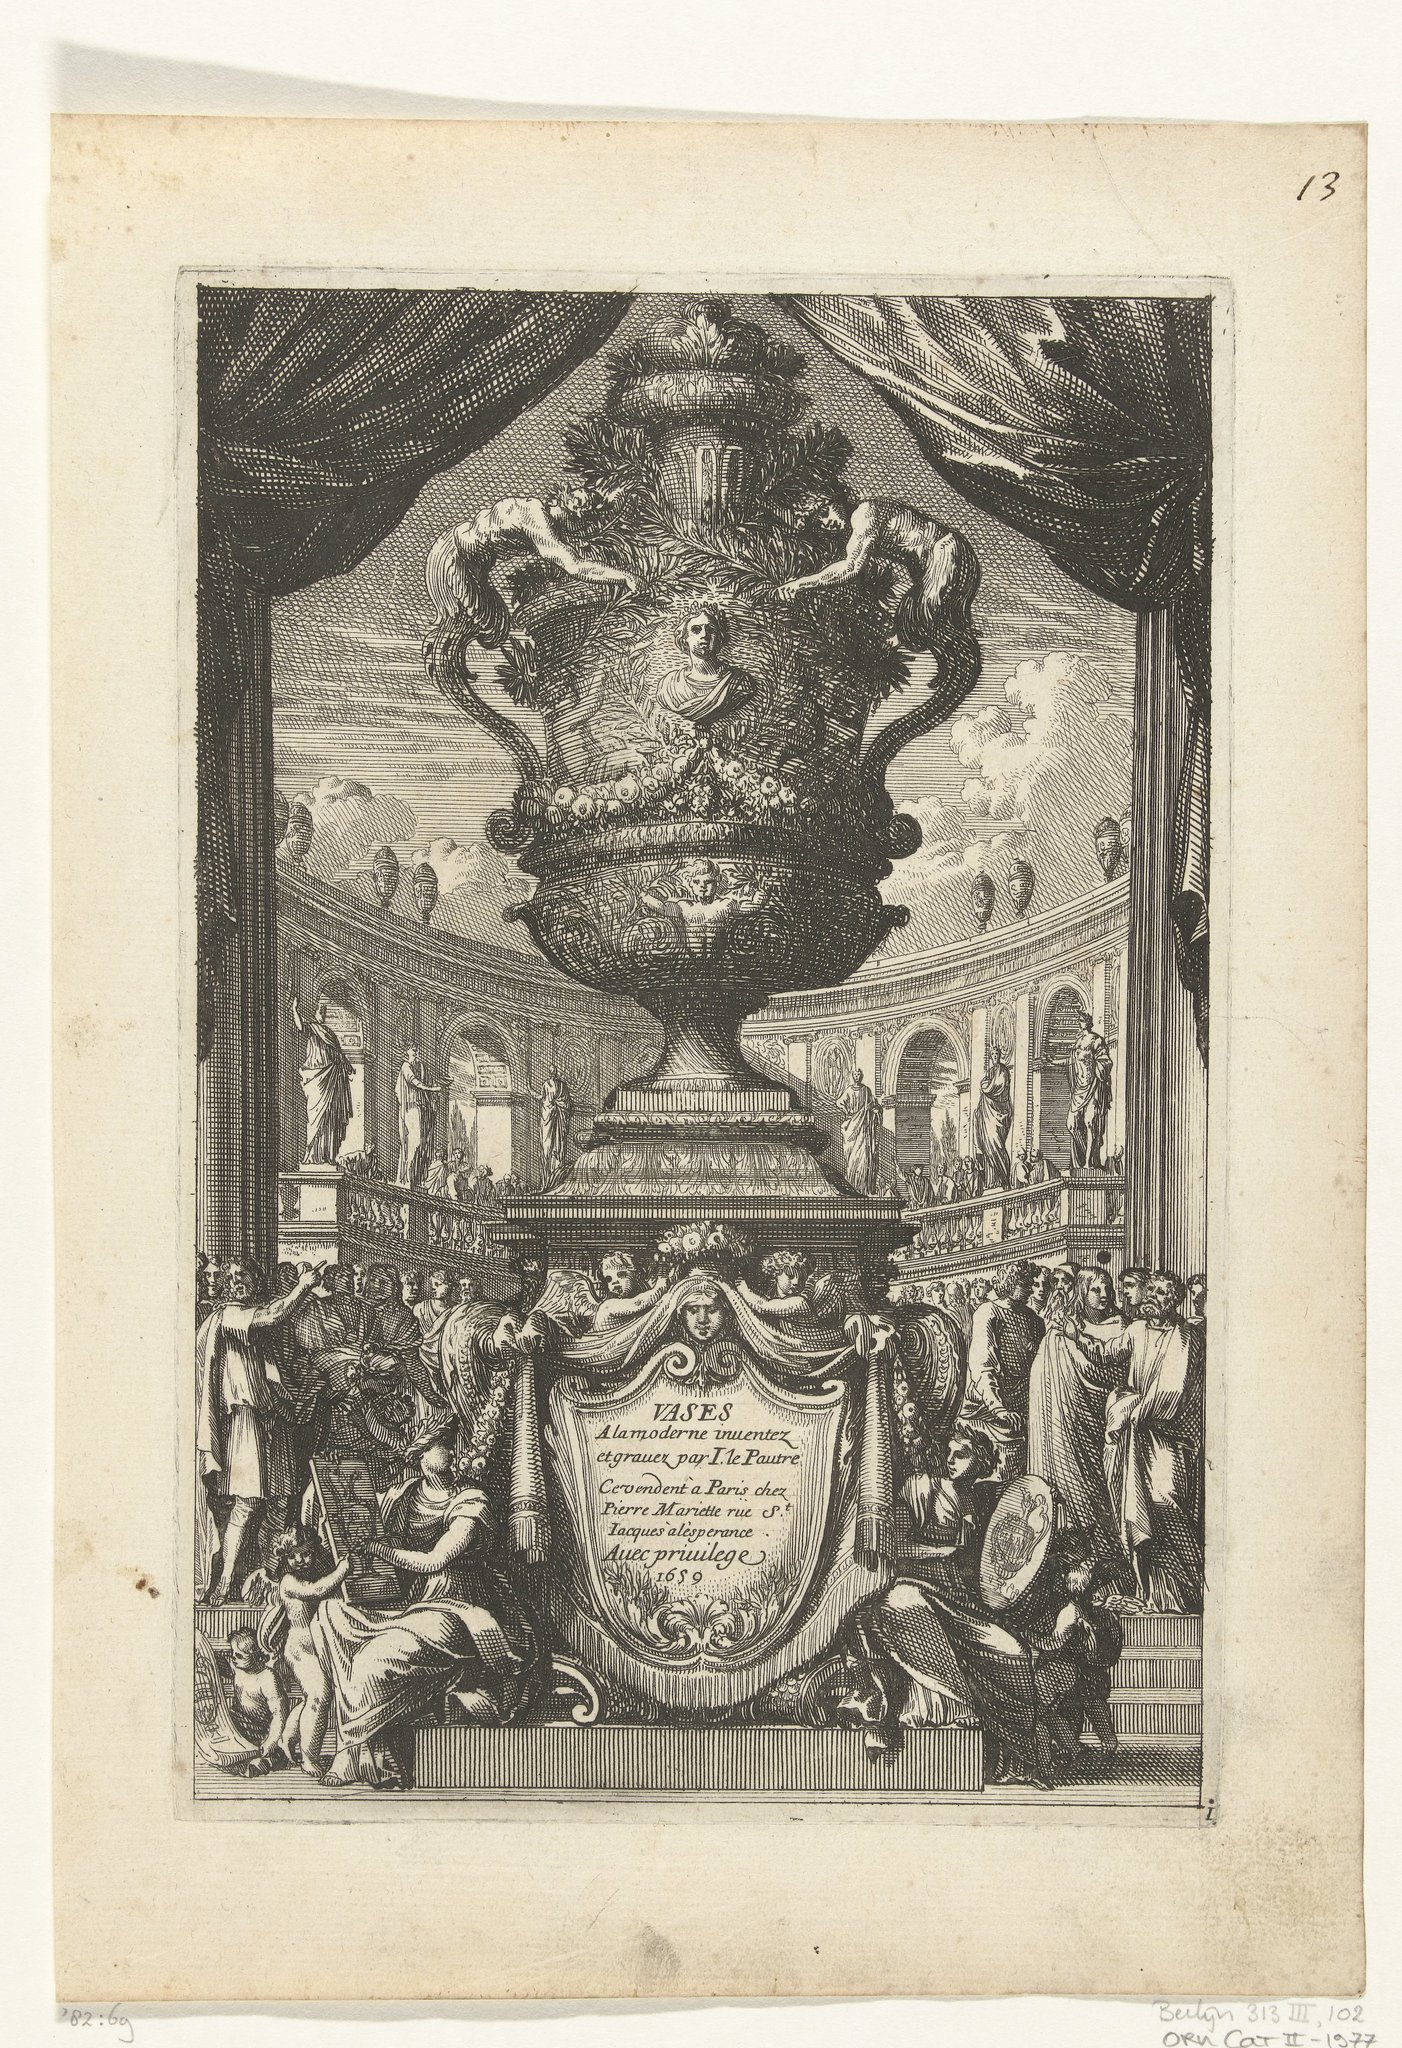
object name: titelblad, titelpagina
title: Titelblad: Vases à la moderne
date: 1659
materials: paper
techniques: etching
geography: paris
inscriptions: number: ‘13’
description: Op het lichaam van de vaas staat een portretbuste, de handvatten hebben de vorm van tritons. De titel van de serie staat onderaan in een cartouche.